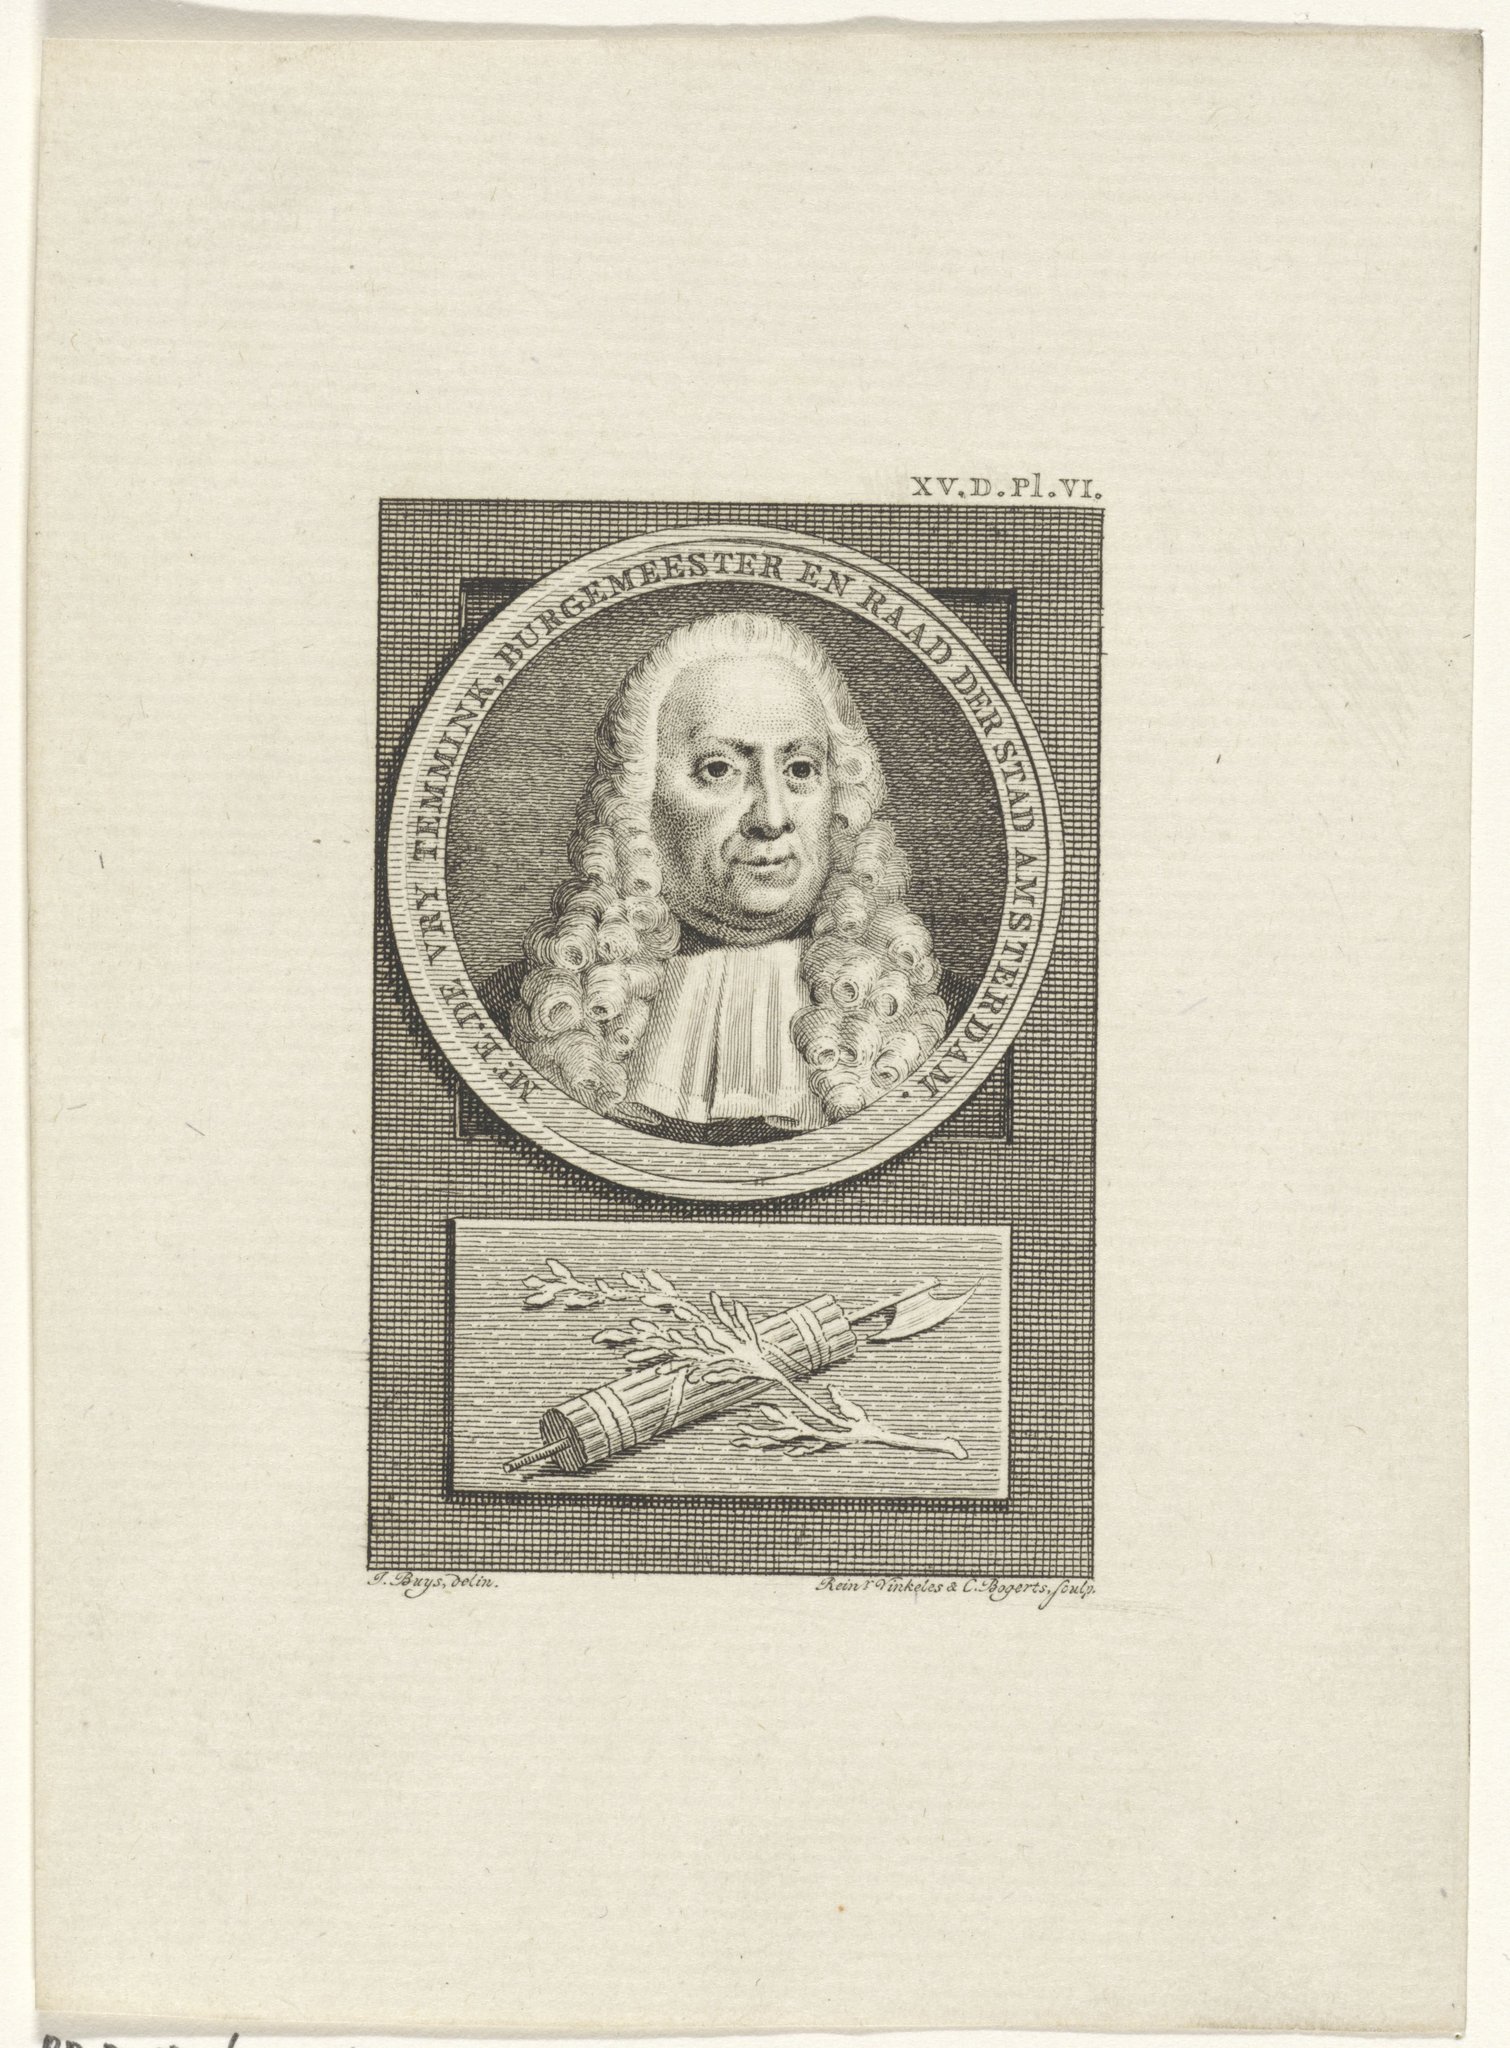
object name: print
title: Portret van Egbert de Vrij Temminck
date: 1783-1795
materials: paper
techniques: engraving, etching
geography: amsterdam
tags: amsterdam, mayor, egbert de vrij temminck, law and jurisprudence (+ 'fasces cum securibus')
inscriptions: collector's mark: Lugt 2228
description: Prent gebruikt in: Fokke, Jan. Geschiedenissen der Vereenigde Nederlanden voor de vaderlandsche jeugd Ie-XXVste deel. Amsterdam: Johannes Allart, 1783-1795. Deel XV.